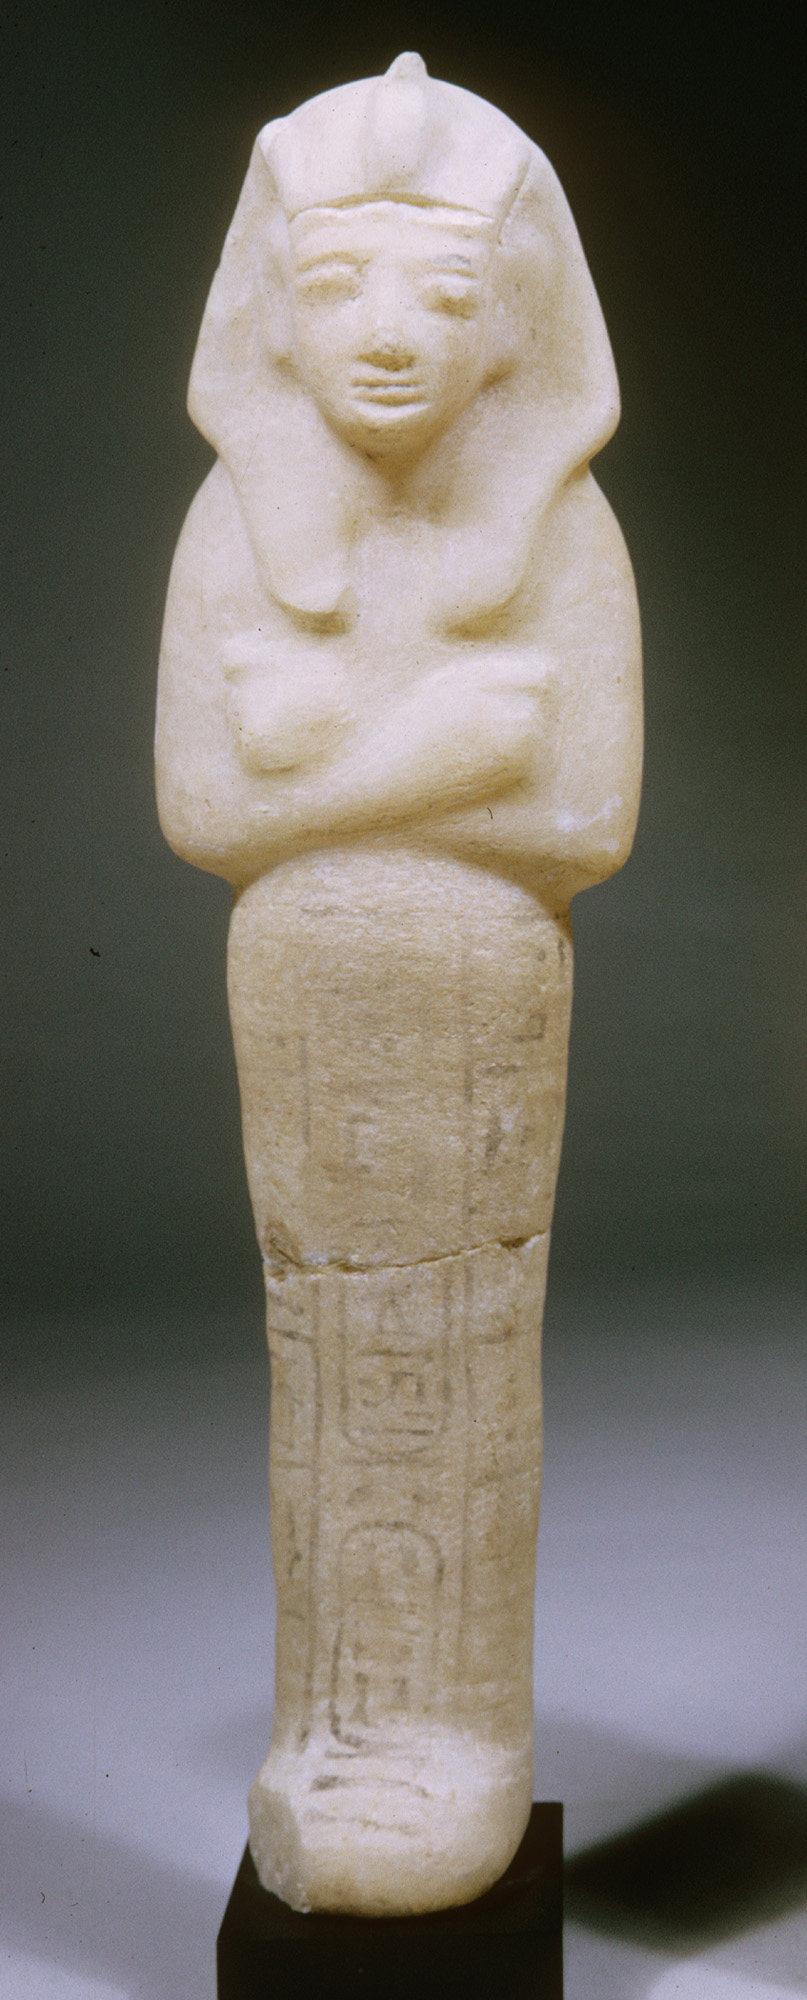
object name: shabti, siptah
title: Shabti of Siptah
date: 1194-1188 BCE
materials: stone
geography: egypt